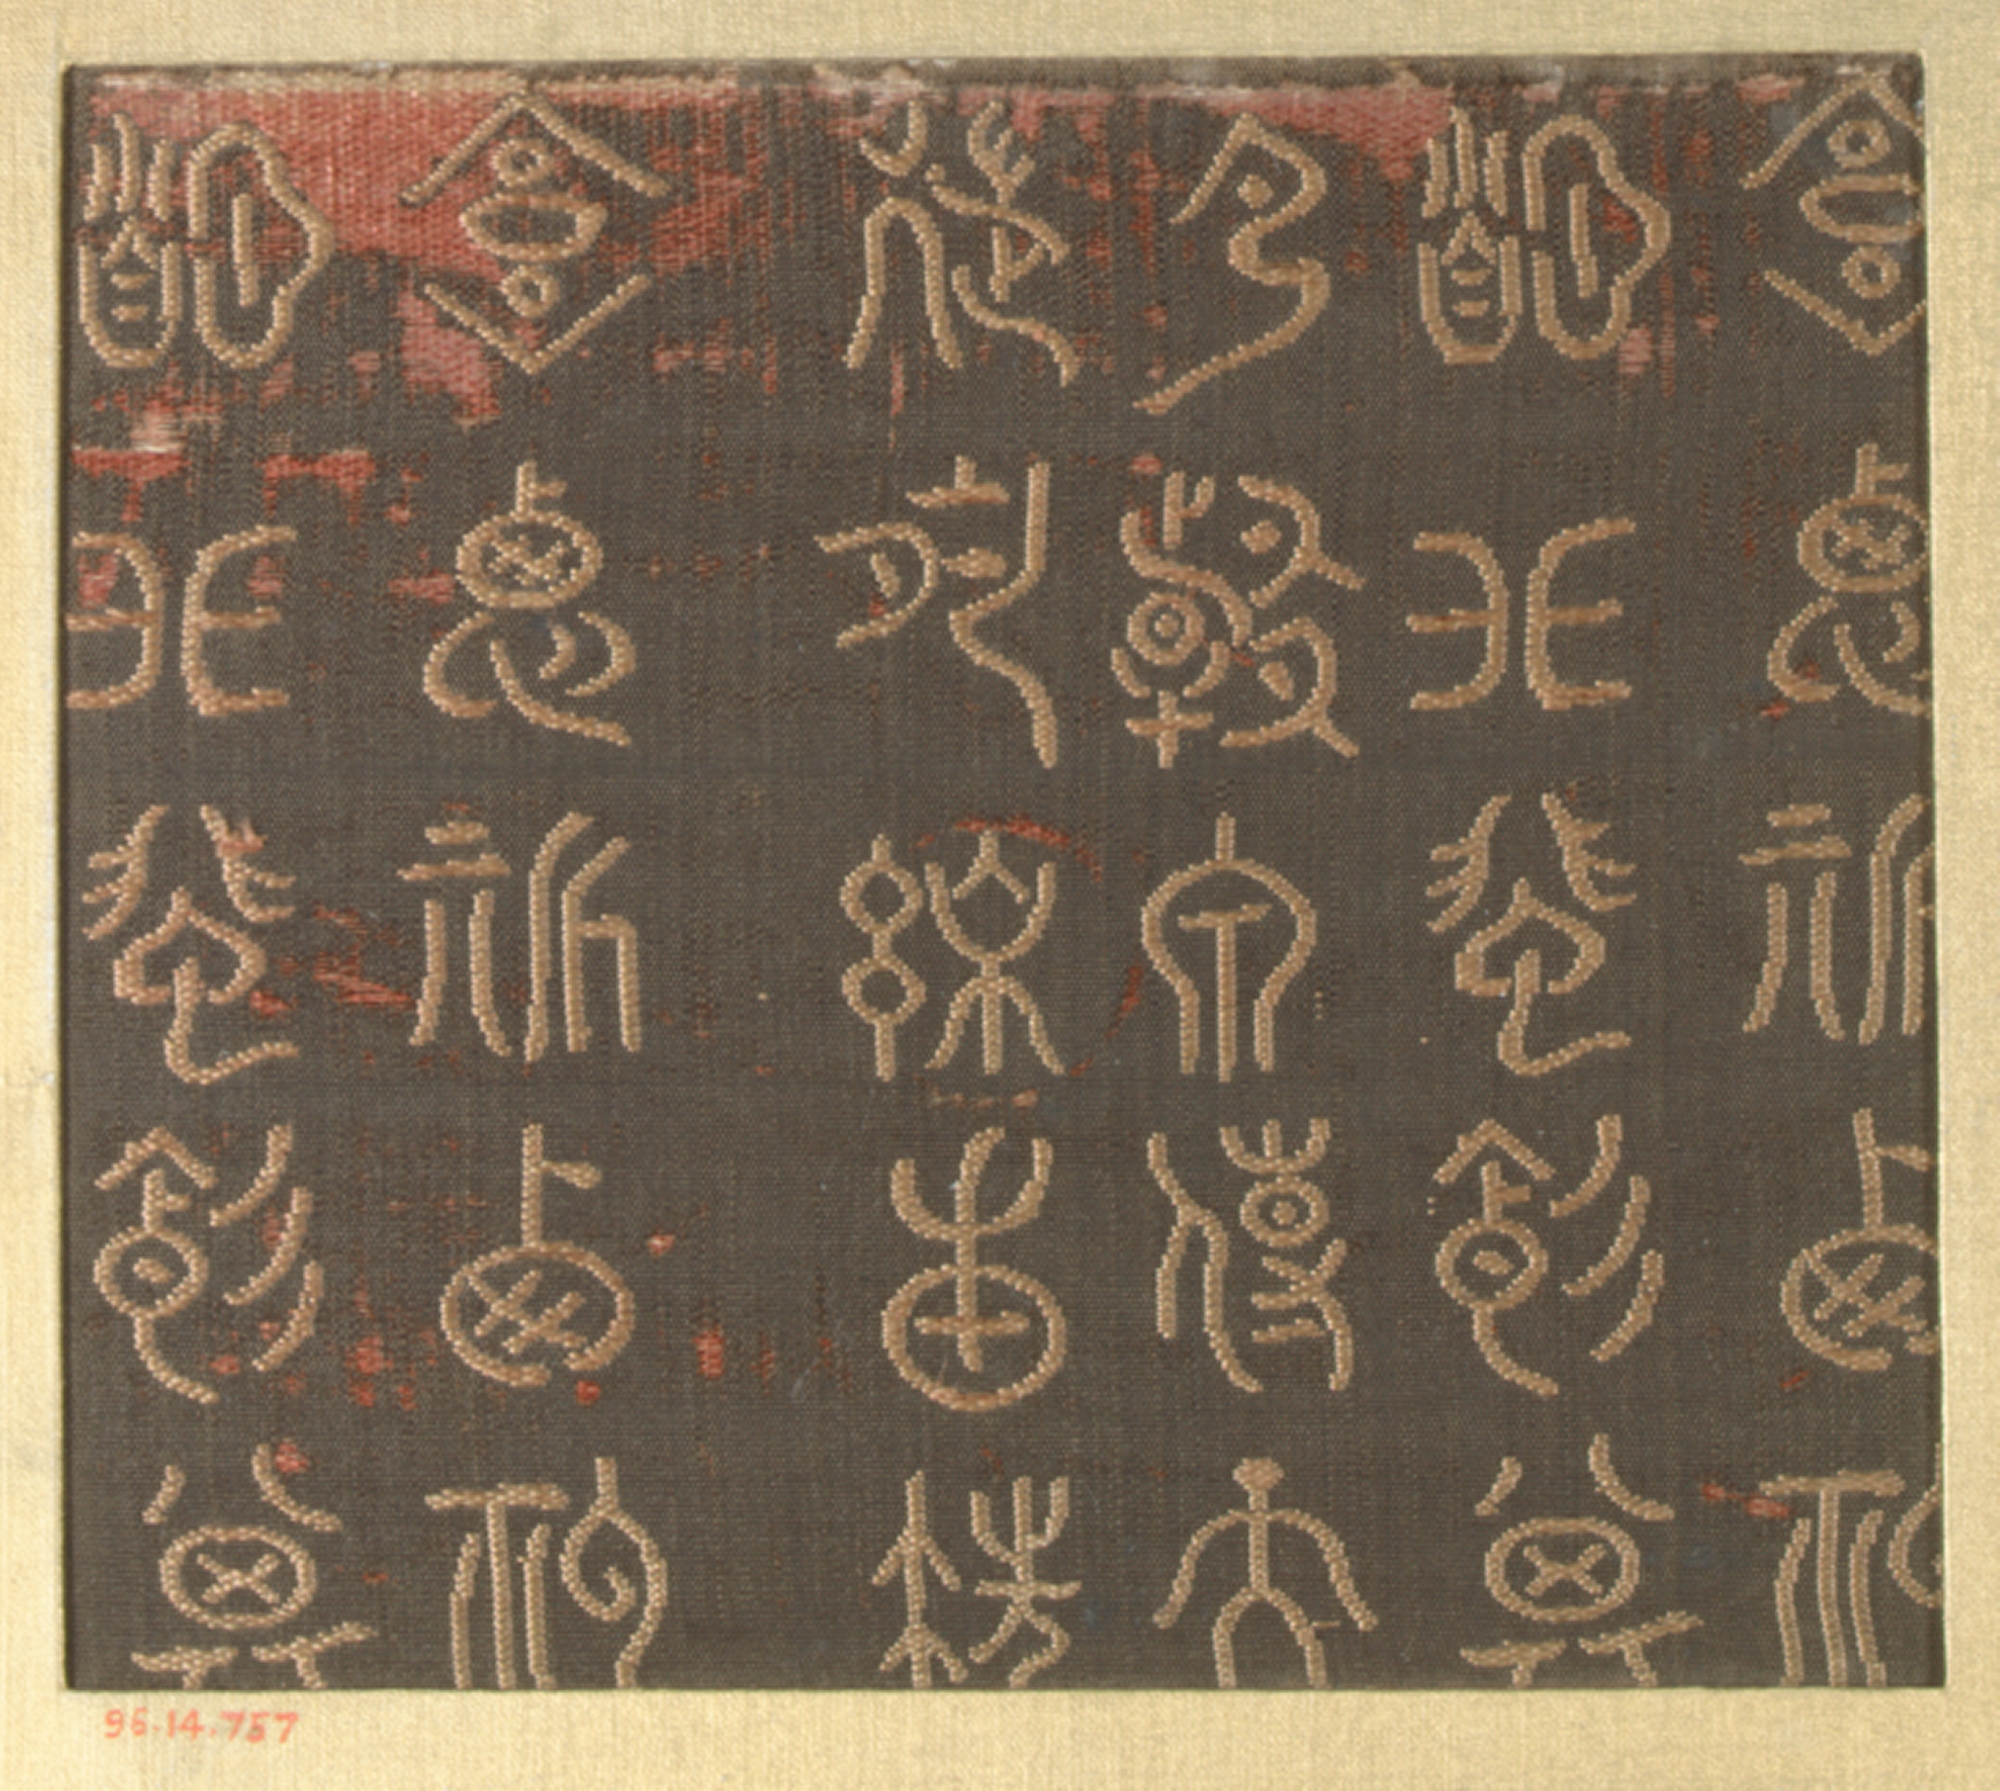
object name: piece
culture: japanese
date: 1701-1900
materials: silk